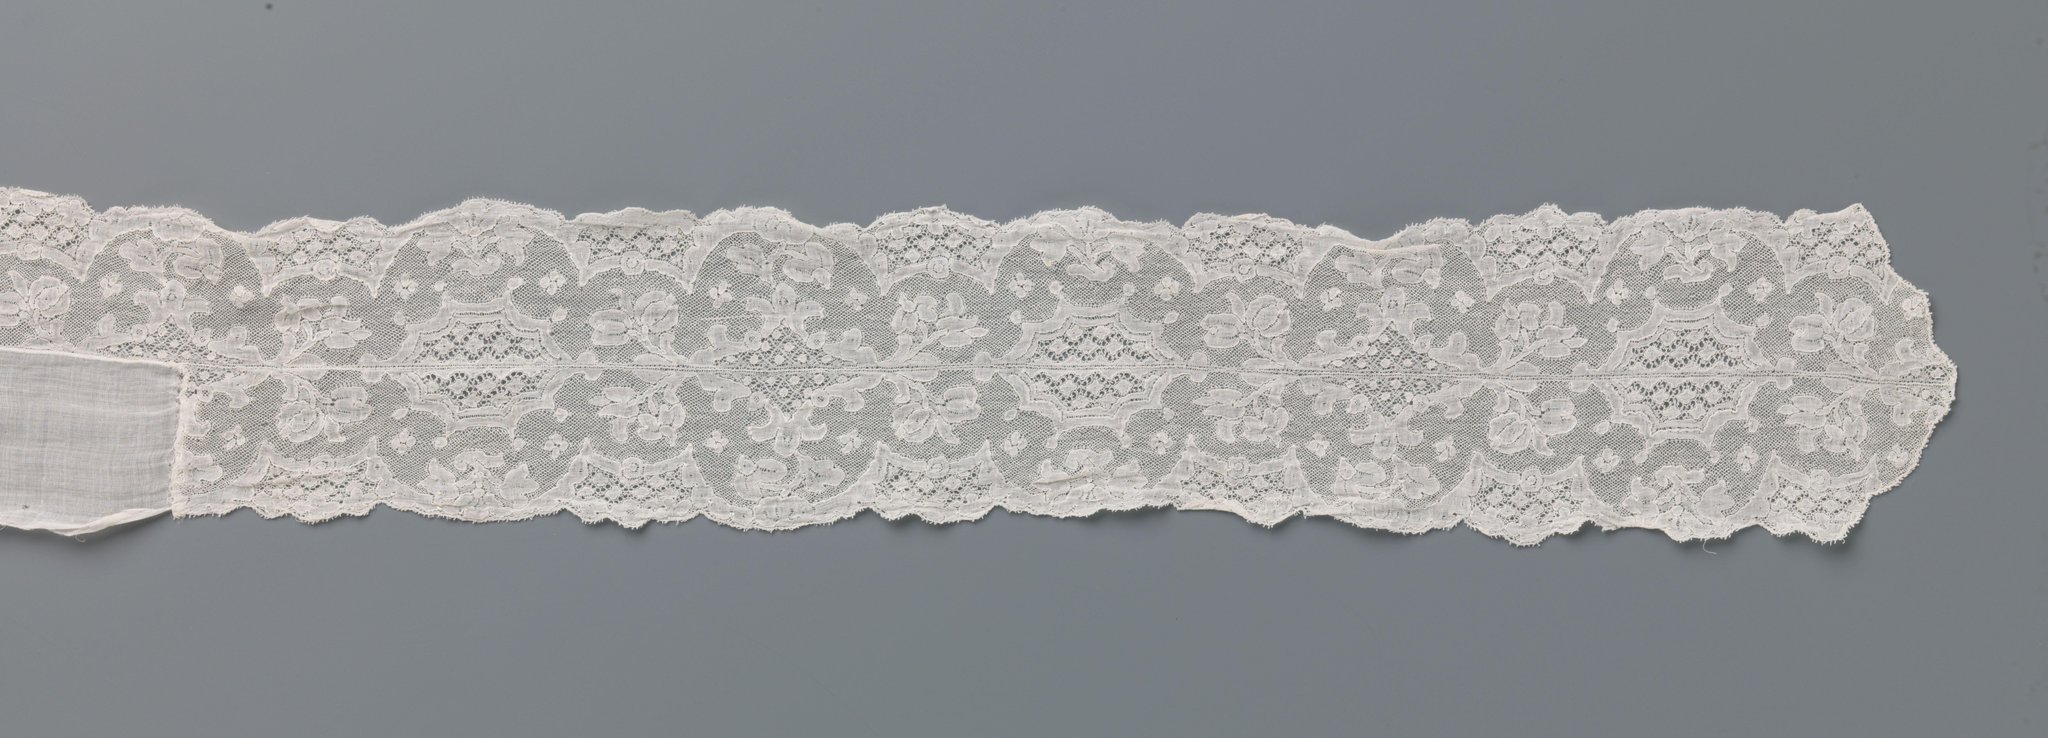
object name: womenswear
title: Mutsenslip van twee aaneengenaaide stroken kloskant met ovale cartouches waarin ruitvormige cartouche met tulpen en tienpuntige cartouches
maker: Anonymous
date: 1725-1749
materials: linen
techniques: lace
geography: europe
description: Mutsenslip van twee in de lengte aaneengenaaide stroken naturelkleurige kloskant, Mechelse kant. In het midden van de strook wordt één van de aan elkaar genaaide stroken onderbroken door een stuk linnen batist, die langs de buitenrand niet is afgewerkt. Het samengevoegde en zich herhalende patroon bestaat in zijn geheel uit aaneengeschakelde en in elkaar overlopende ovale cartouches, met daarin twee elkaar afwisselende symmetrische motieven. Het ene motief betreft een ruitvormige cartouche waaruit links en rechts uit de punt takken met tulpen ontspringen. Het andere motief is een tienpuntige cartouche. De korte zijden zijn afgerond en de gehele buitenrand is geschulpt en afgewerkt met picots.